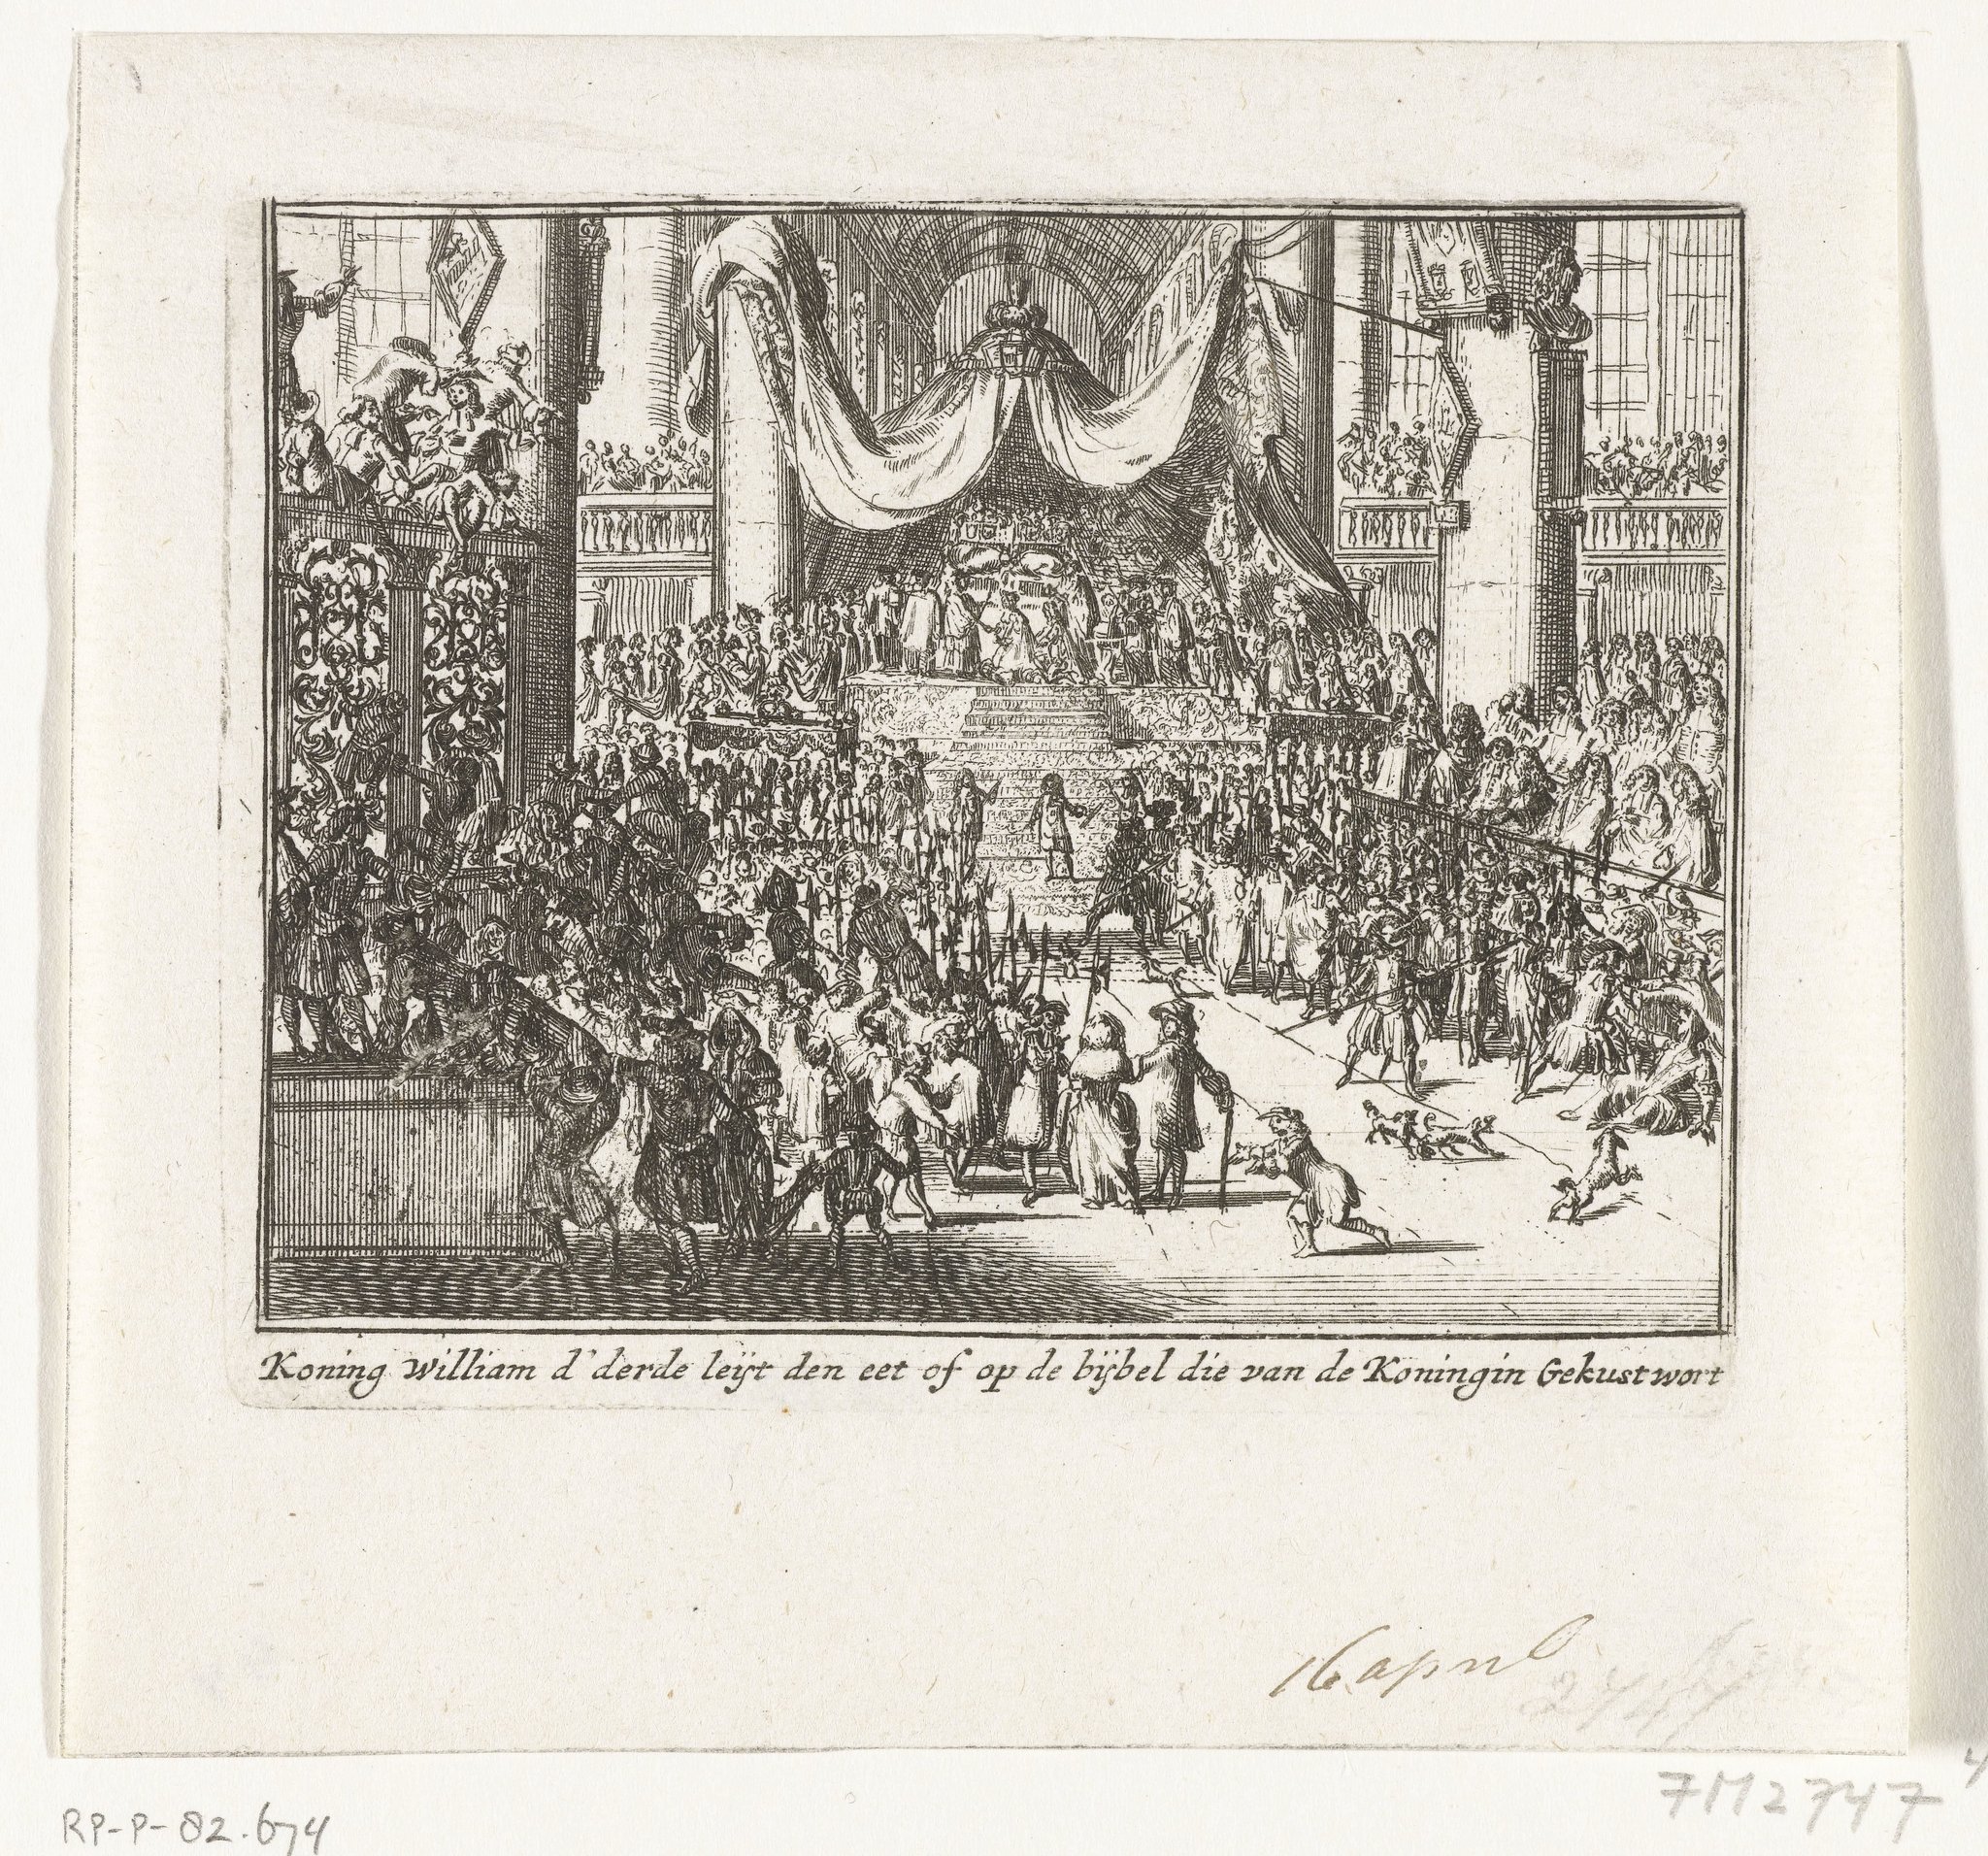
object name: print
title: Koning William d'derde leyt den eet of op de bybel die van de Koningin Gekust wort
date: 1711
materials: paper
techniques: etching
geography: northern netherlands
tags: the hague, william iii (prince of orange and king of england, scotland, and ireland), london, maria ii stuart (koningin van engeland, schotland en ierland), new ruler taking the oath, coronation of a ruler, westminster abbey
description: Tijdens de kroningsceremonie legt Willem III de eed af op de bijbel, Maria kust de bijbel, 21 april 1689. Onderdeel van een serie over de lotgevallen van het Engelse koningshuis van Stuart van 1558-1711, waarvan hier zijn opgenomen zestien prenten over de strijd tussen Jacobus II en Willem III in de jaren 1688-1689.